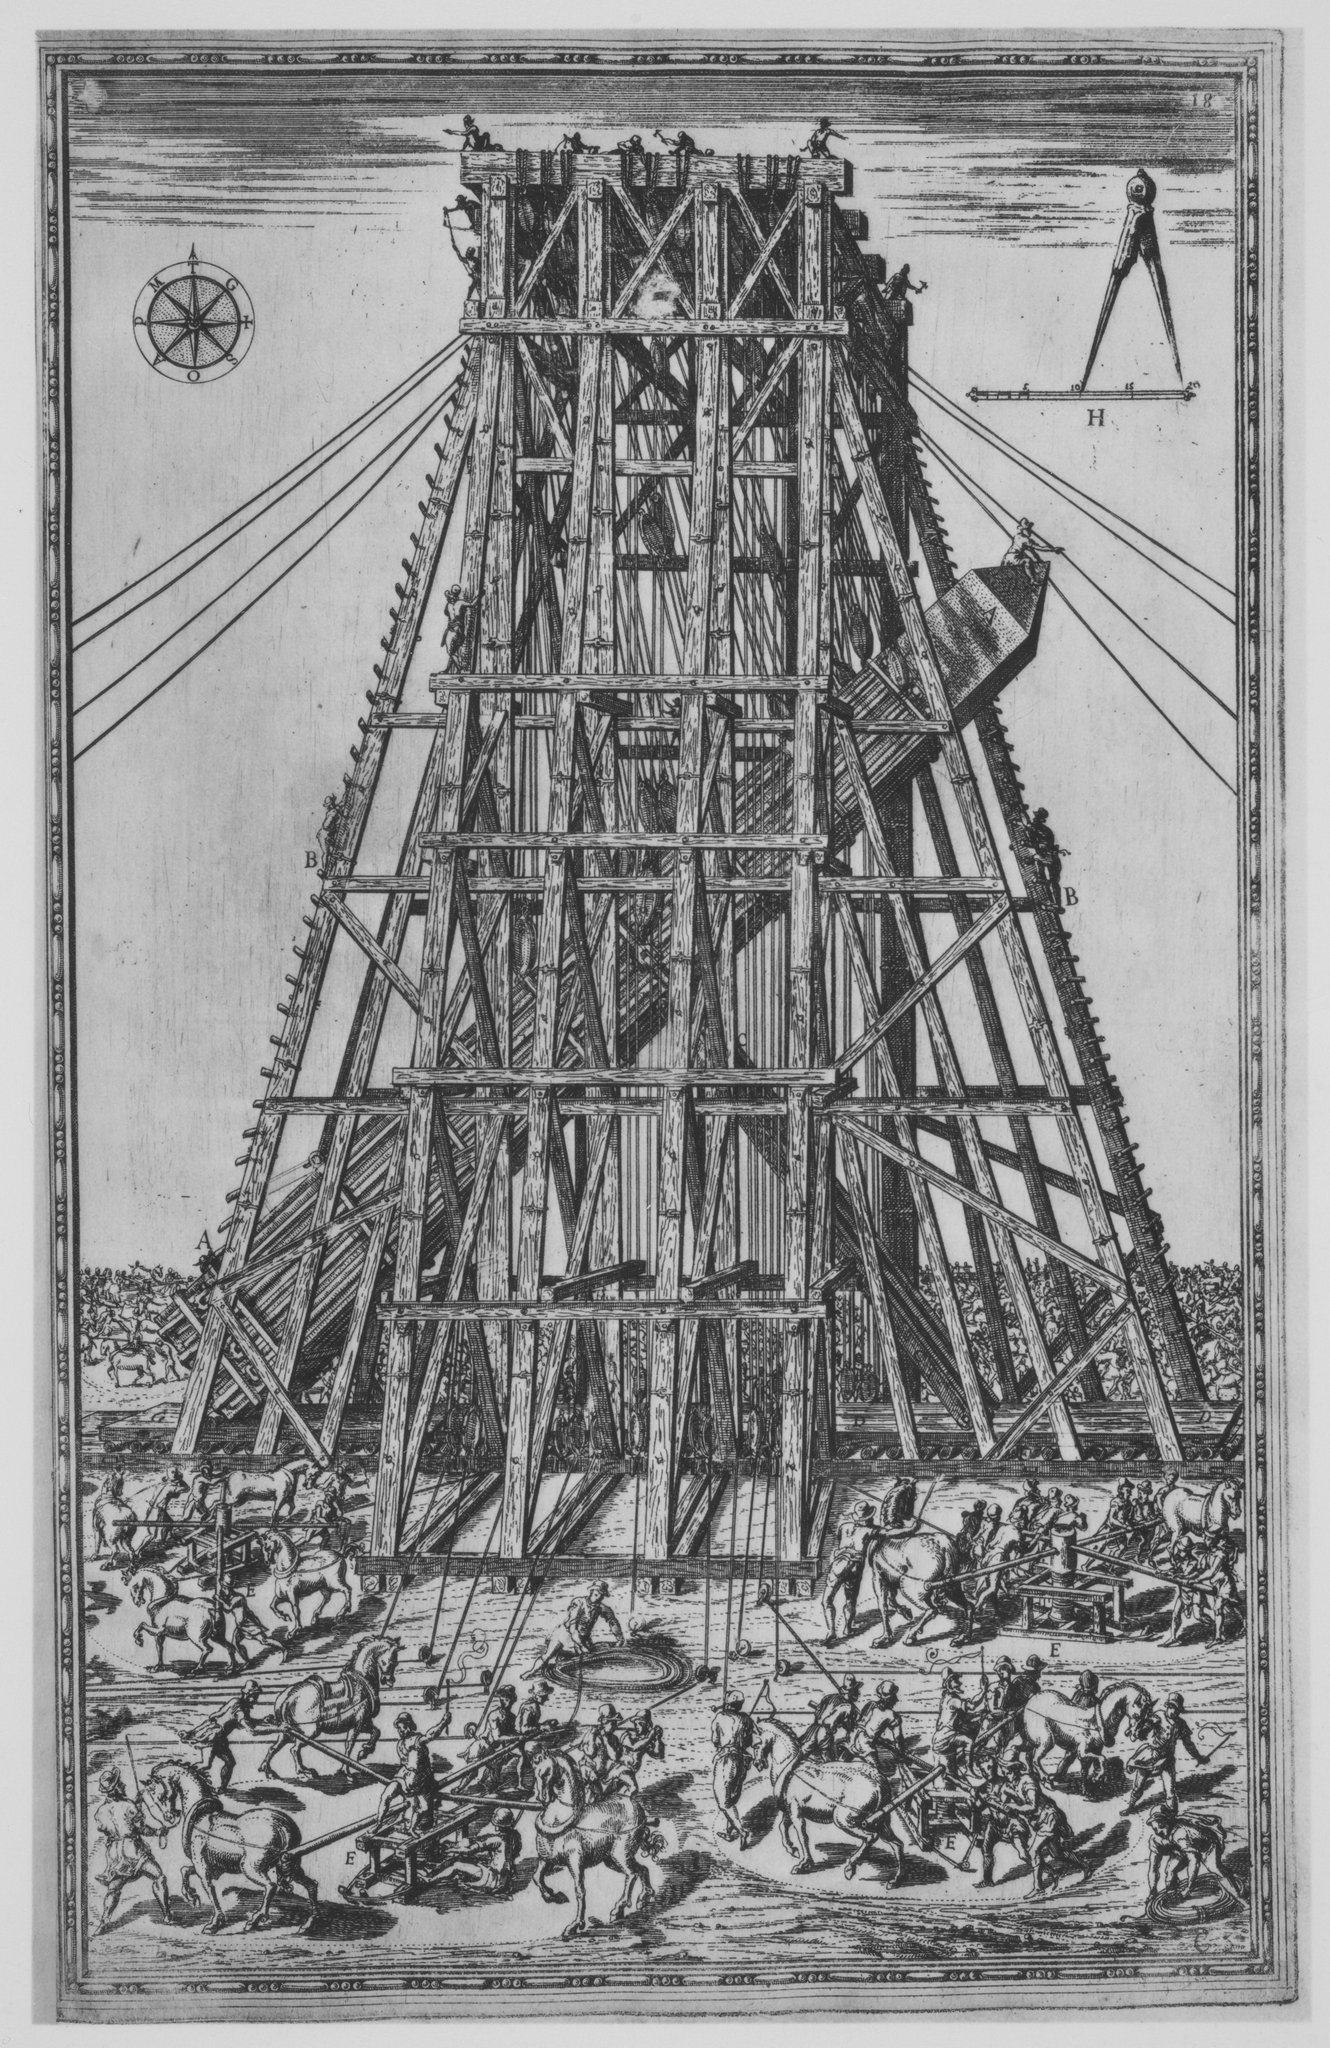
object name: book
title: Della Trasportatione dell'Obelisco Vaticano et delle Fabriche di Nostro Signore Papa Sisto V fatte dal Cavallier Domenico Fontana Architetto di sua Santita Libro Primo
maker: domenico fontana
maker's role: author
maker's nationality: italian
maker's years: 1543-1607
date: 1590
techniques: engraving, printing, woodcut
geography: italy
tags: obelisks,men,horses,working